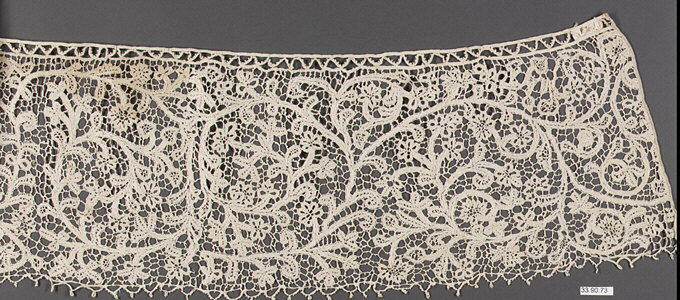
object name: flounce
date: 1601-1633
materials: lace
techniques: lace